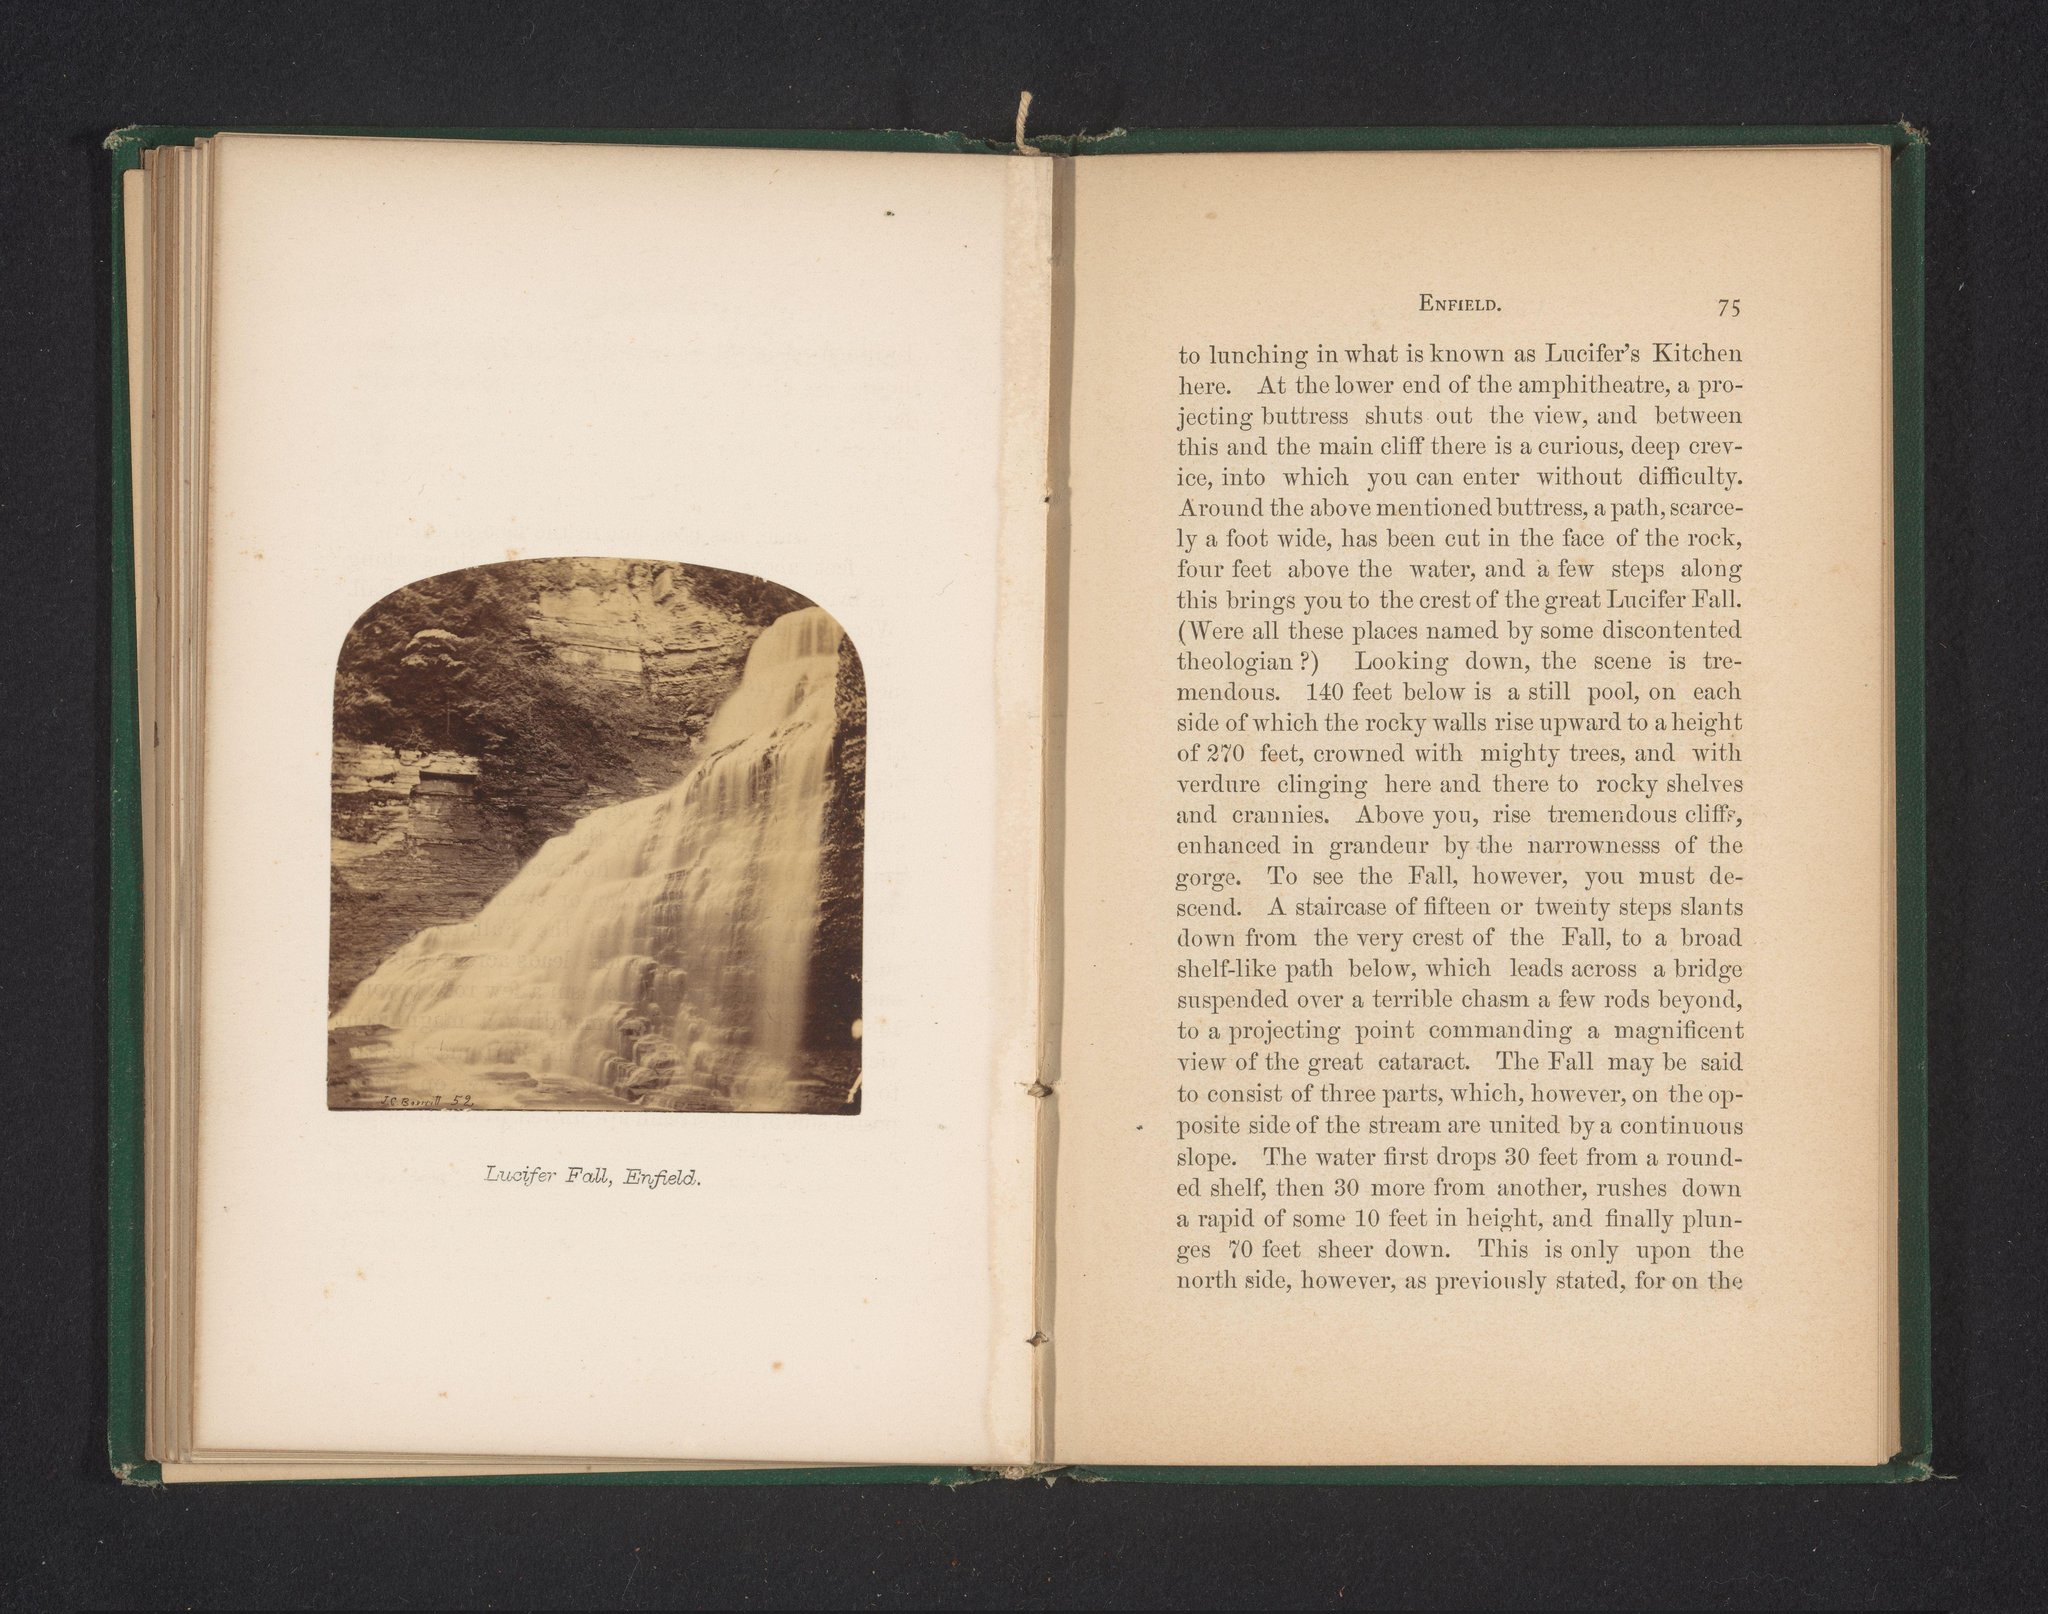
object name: photograph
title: Lucifer Fall, Enfield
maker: joseph curtiss burritt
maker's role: fotograaf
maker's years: 1817-1889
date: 1864-1869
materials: photographic support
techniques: albumen print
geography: new york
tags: waterfall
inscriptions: number: ‘52’